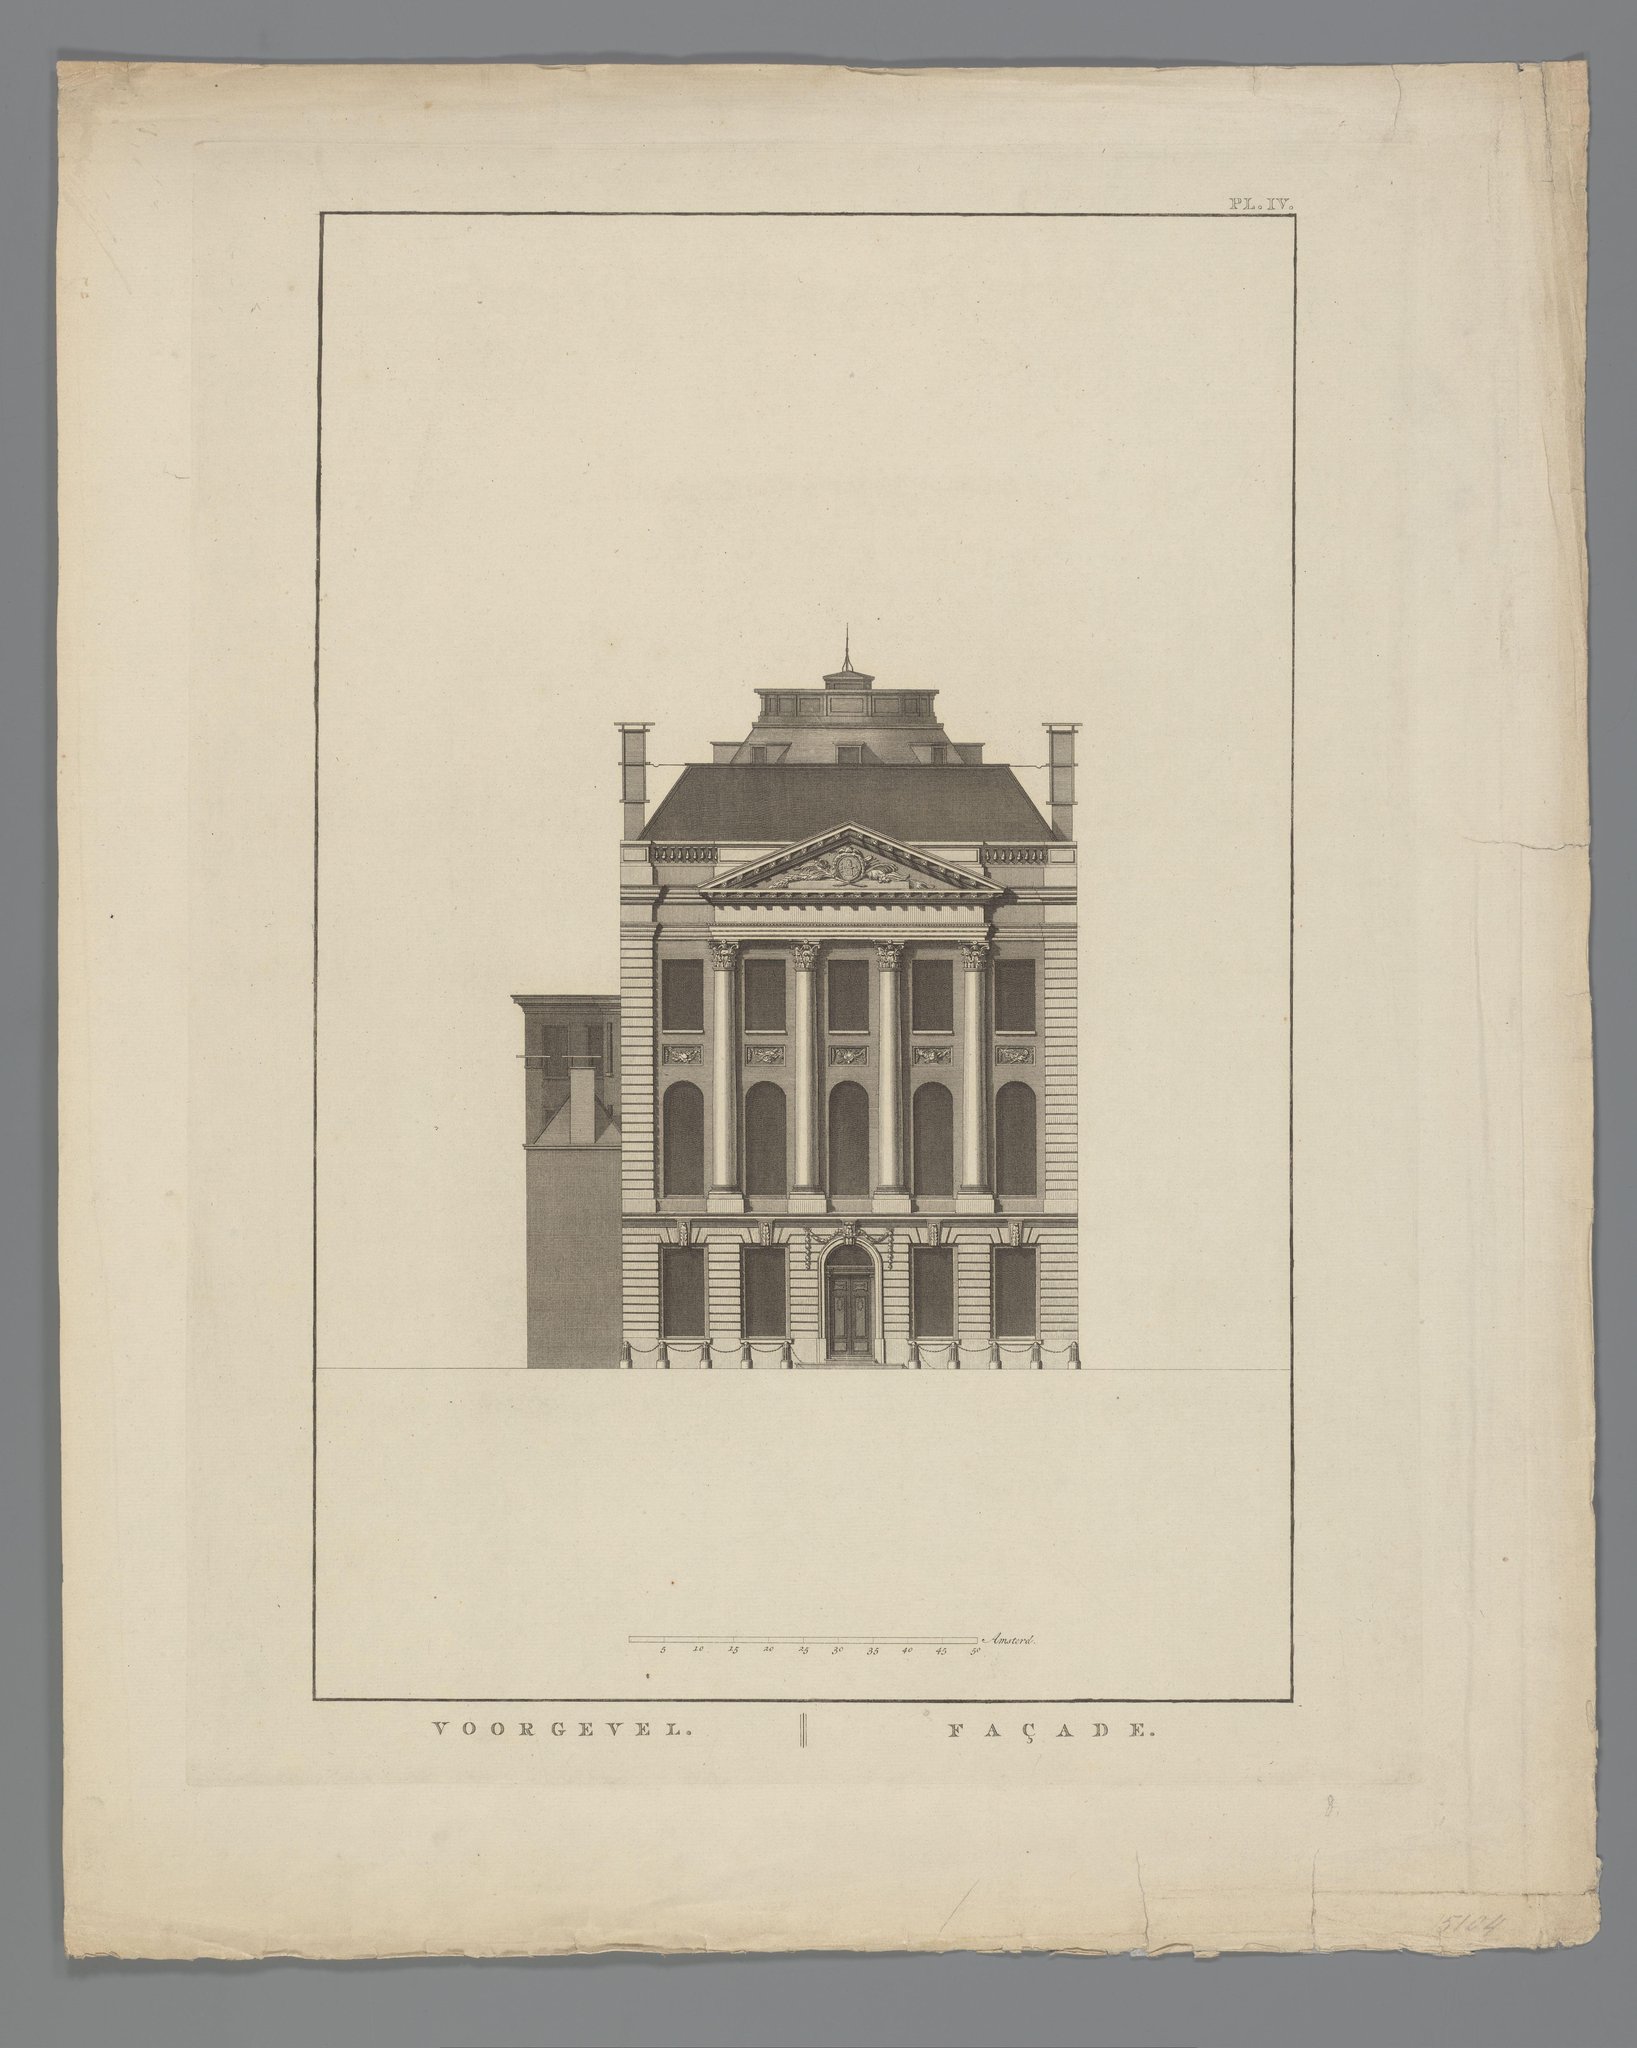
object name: print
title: Voorgevel / Façade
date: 1789-1799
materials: paper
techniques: etching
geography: amsterdam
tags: architectural design or model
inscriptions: collector's mark: Lugt 2233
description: Felix Meritis is de naam van een voormalig genootschap en het bijbehorende gebouw aan de Keizersgracht 324 te Amsterdam. Van 1988 tot 2014 was de Stichting Felix Meritis in het pand gevestigd met een Europees Centrum voor Kunst, Cultuur en Wetenschap. Prent uit: Grondteekeningen van het gebouw der Maatschapije van verdiensten, ter spreuke voerende : Felix Meritis (...). = Détails d'architecture de l'edifice de la Société (...) Felix Meritis. Amsterdam: Cornelis Sebille Roos, [1789-1799].